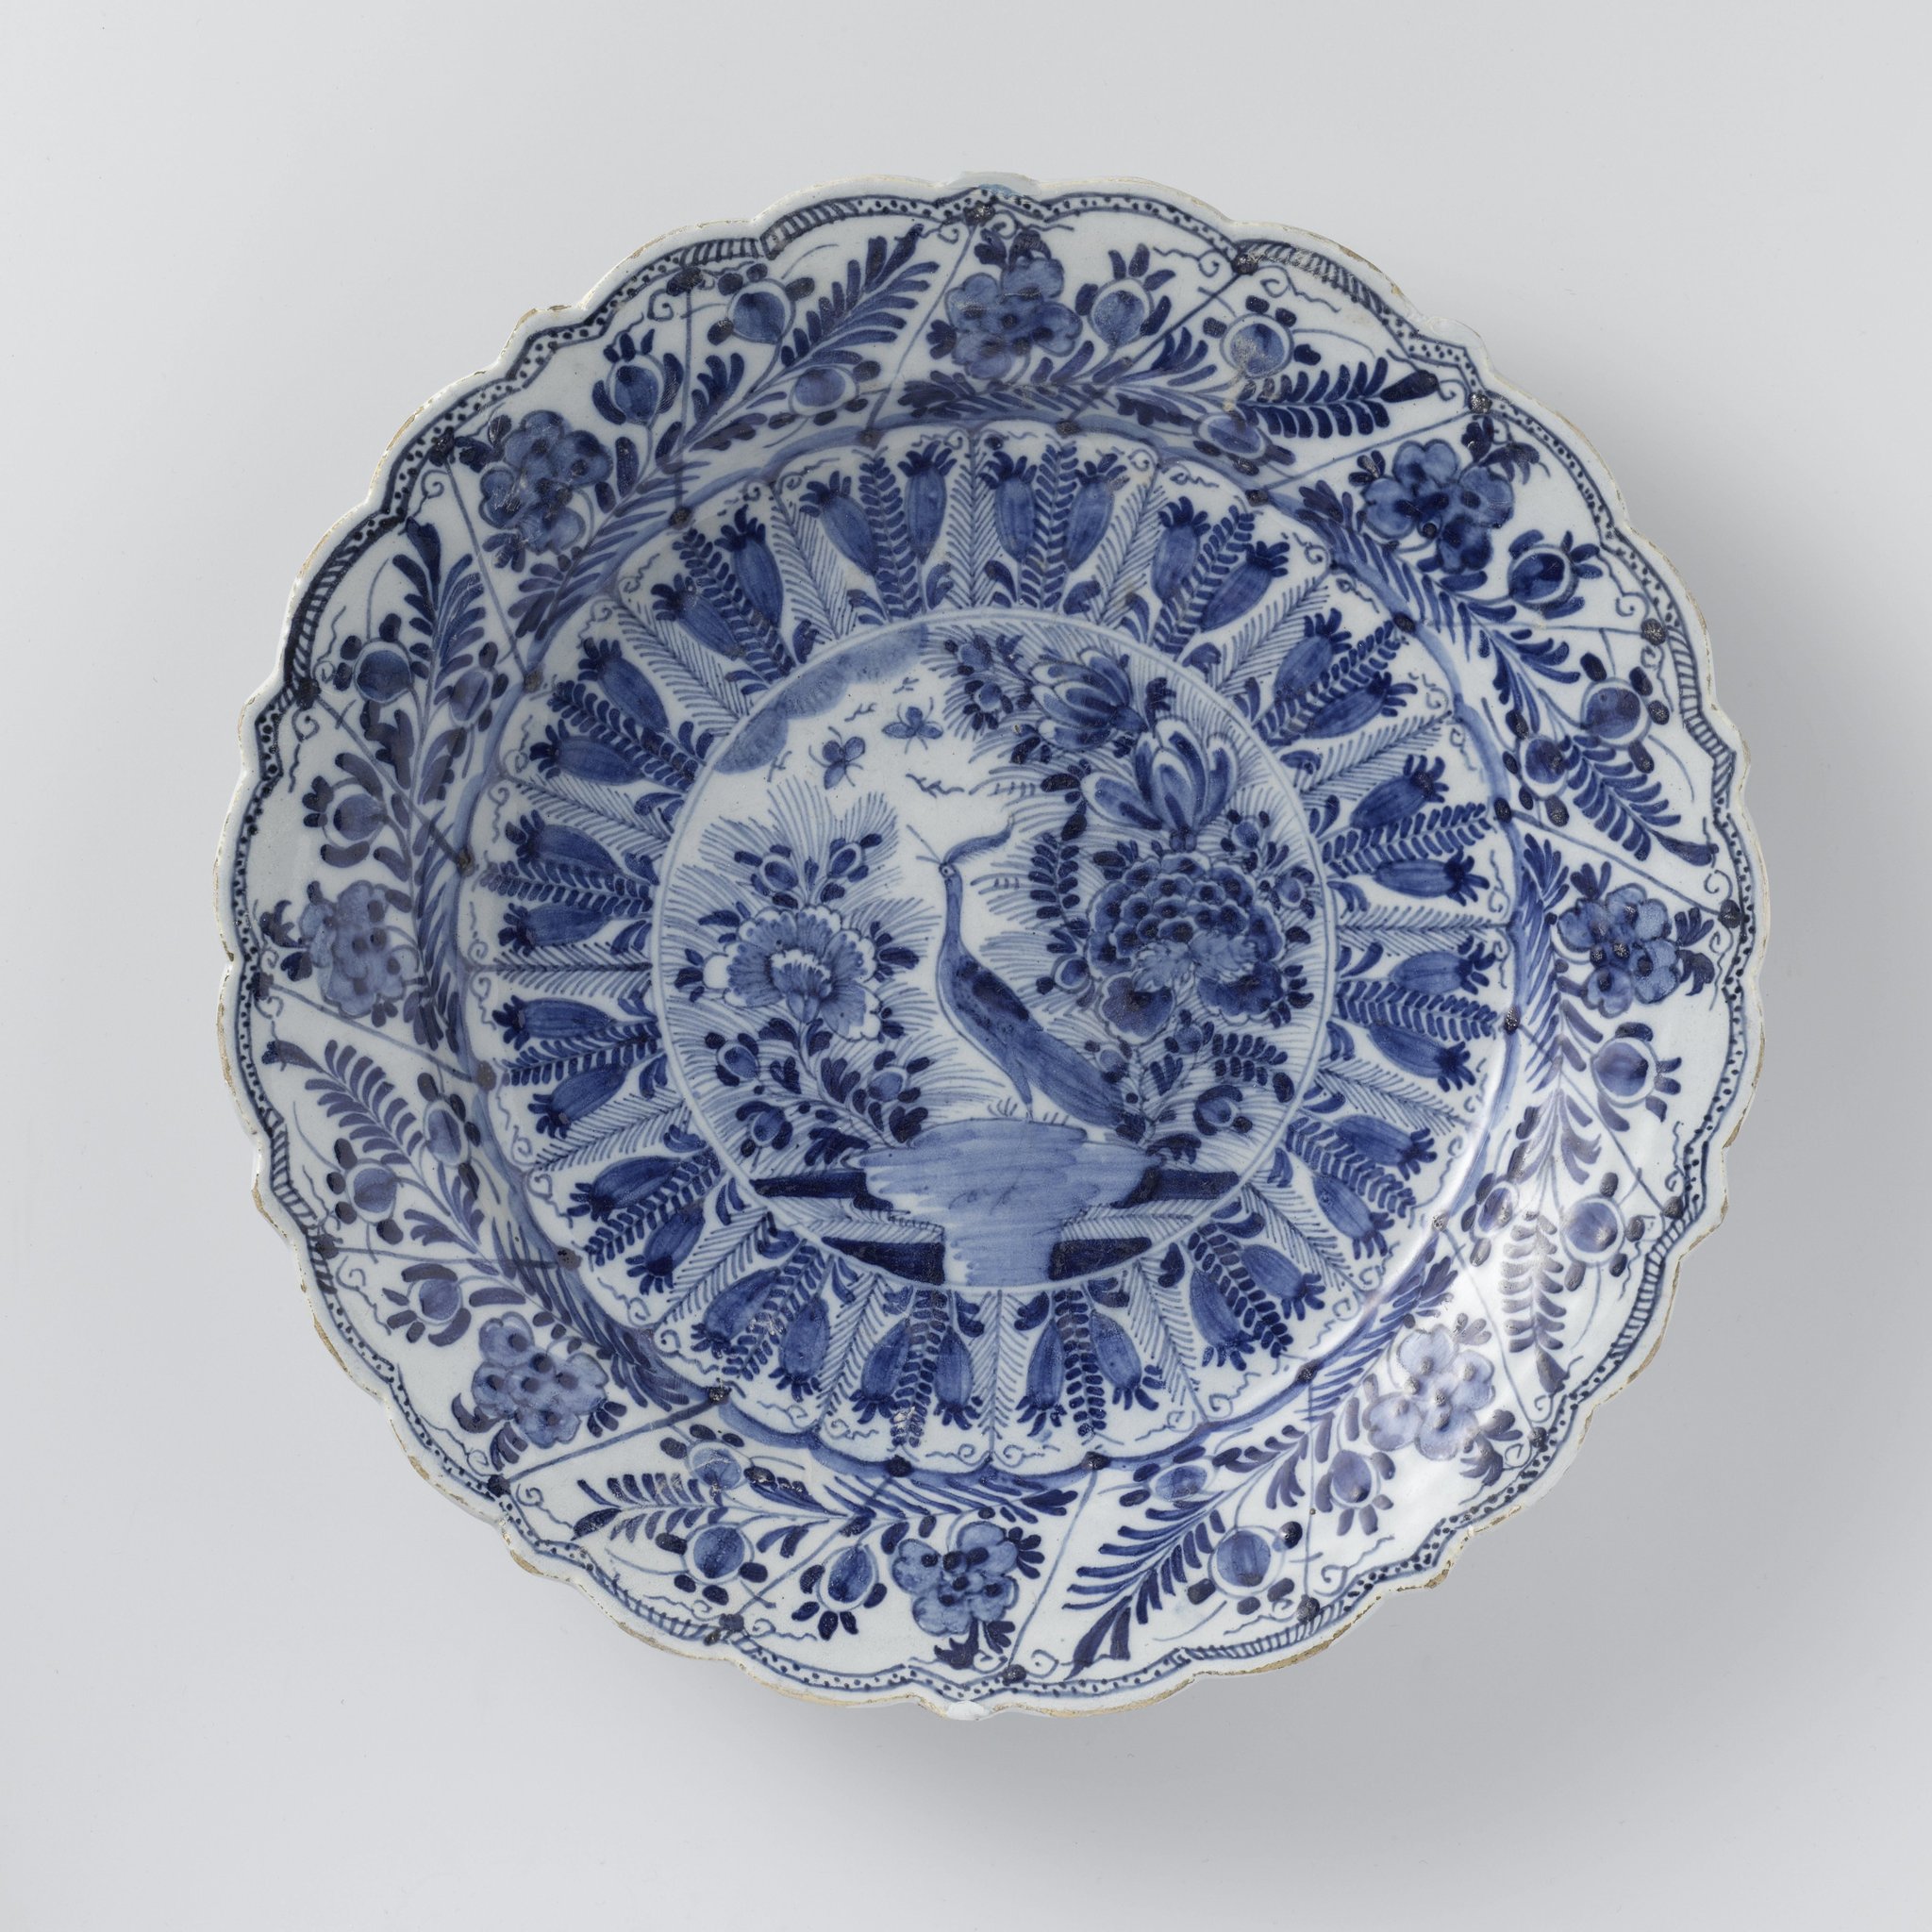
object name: platter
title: Schotel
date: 1740-1790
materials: earthenware, glaze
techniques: painted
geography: delft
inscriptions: mark: ‘L P Kam (L heeft een dubbele staande streep)’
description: Ronde schotel van blauw geschilderde faience, met een geschulpte rand en versierd met het reigerpatroon. De schotel is gemerkt: LP kan Delft Fabr. Bij de schotel horen zes identieke schotels met invnrs. BK-NM-13284-a, BK-NM-13284-b, BK-NM-13284-c, BK-NM-13284-d, BK-NM-13284-f en BK-NM-13284-g.